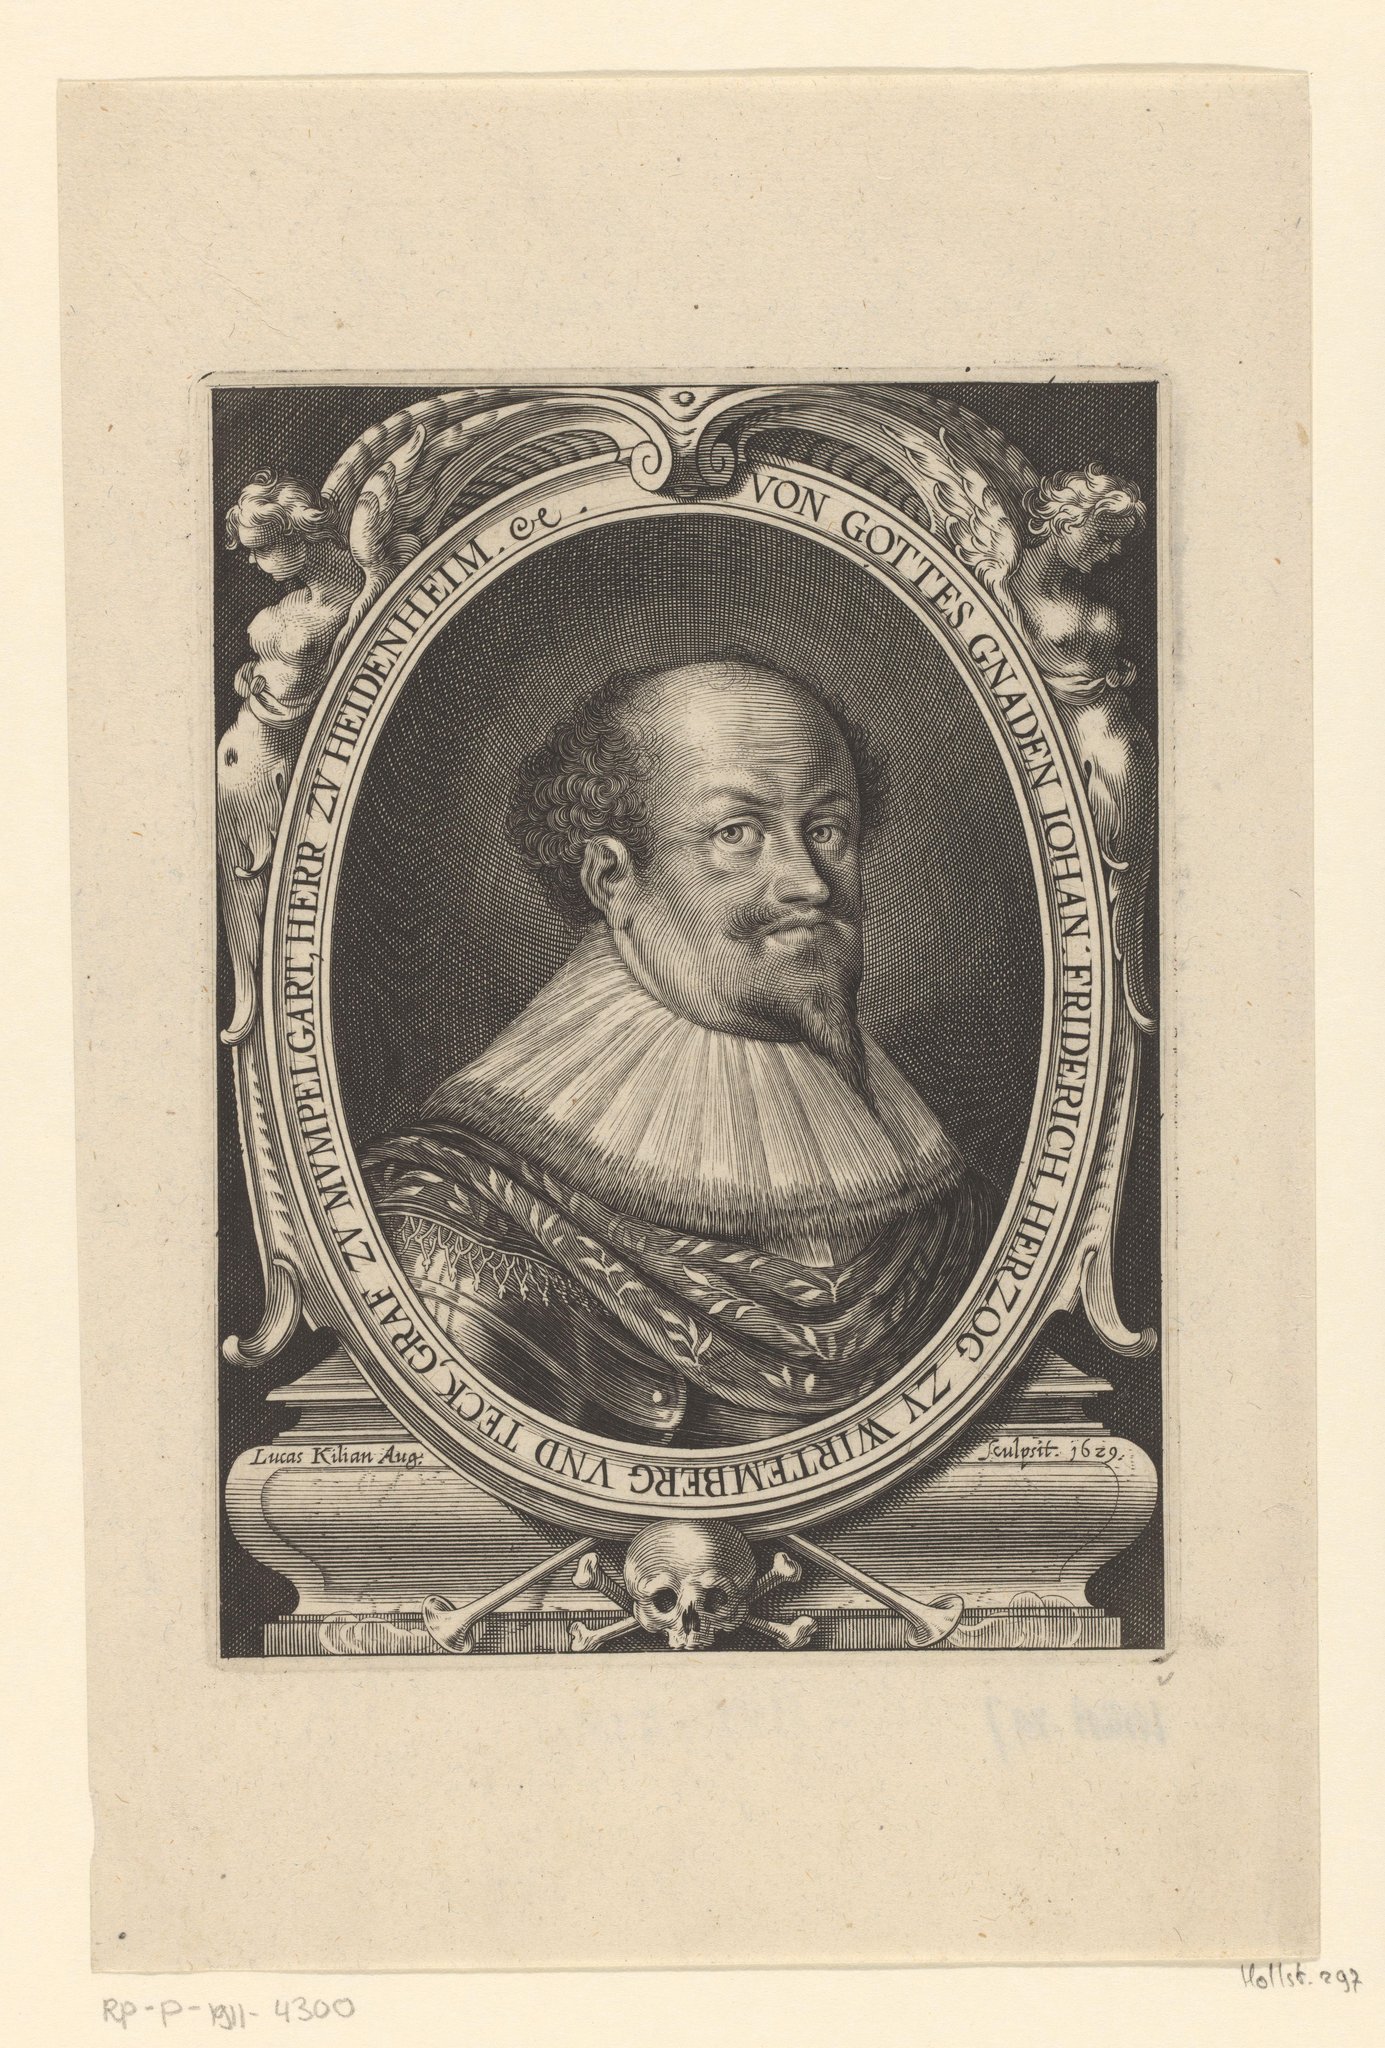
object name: print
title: Portret van Johann Friedrich von Württemberg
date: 1629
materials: paper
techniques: engraving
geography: augsburg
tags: johann friedrich von württemberg (hertog), historical persons, grave-building, monumental tomb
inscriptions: collector's mark: Lugt 2228